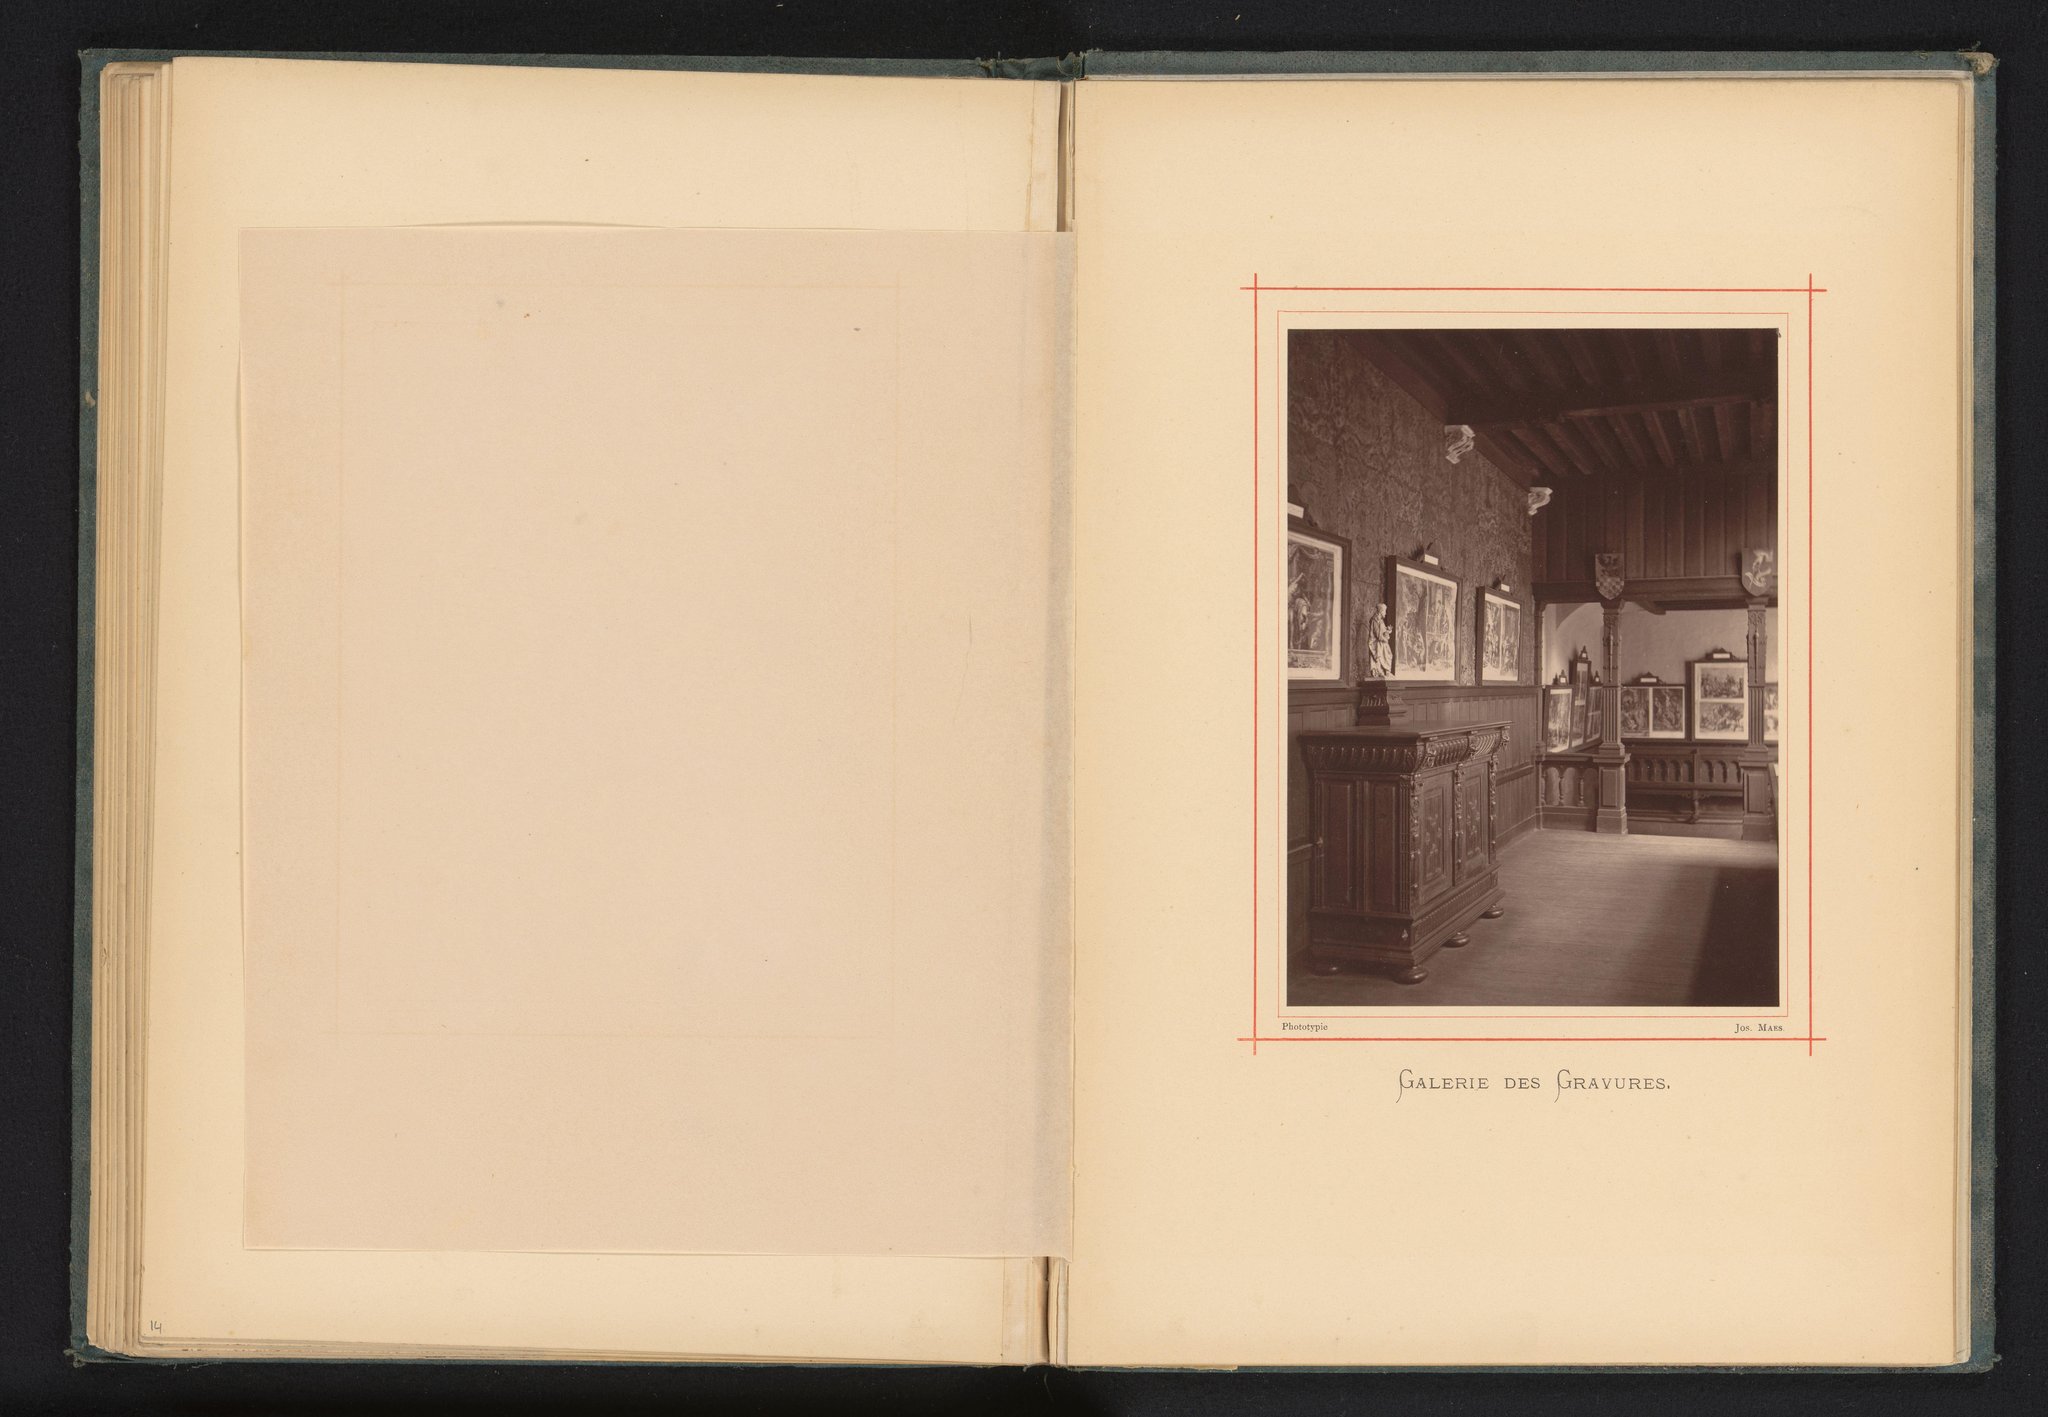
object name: photomechanical print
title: Galerie des gravures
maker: joseph maes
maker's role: fotograaf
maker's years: 1838-1908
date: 1873-1878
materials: paper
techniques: woodburytype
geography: antwerp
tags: print, e.g.: engraving, etching, lithograph, other rooms